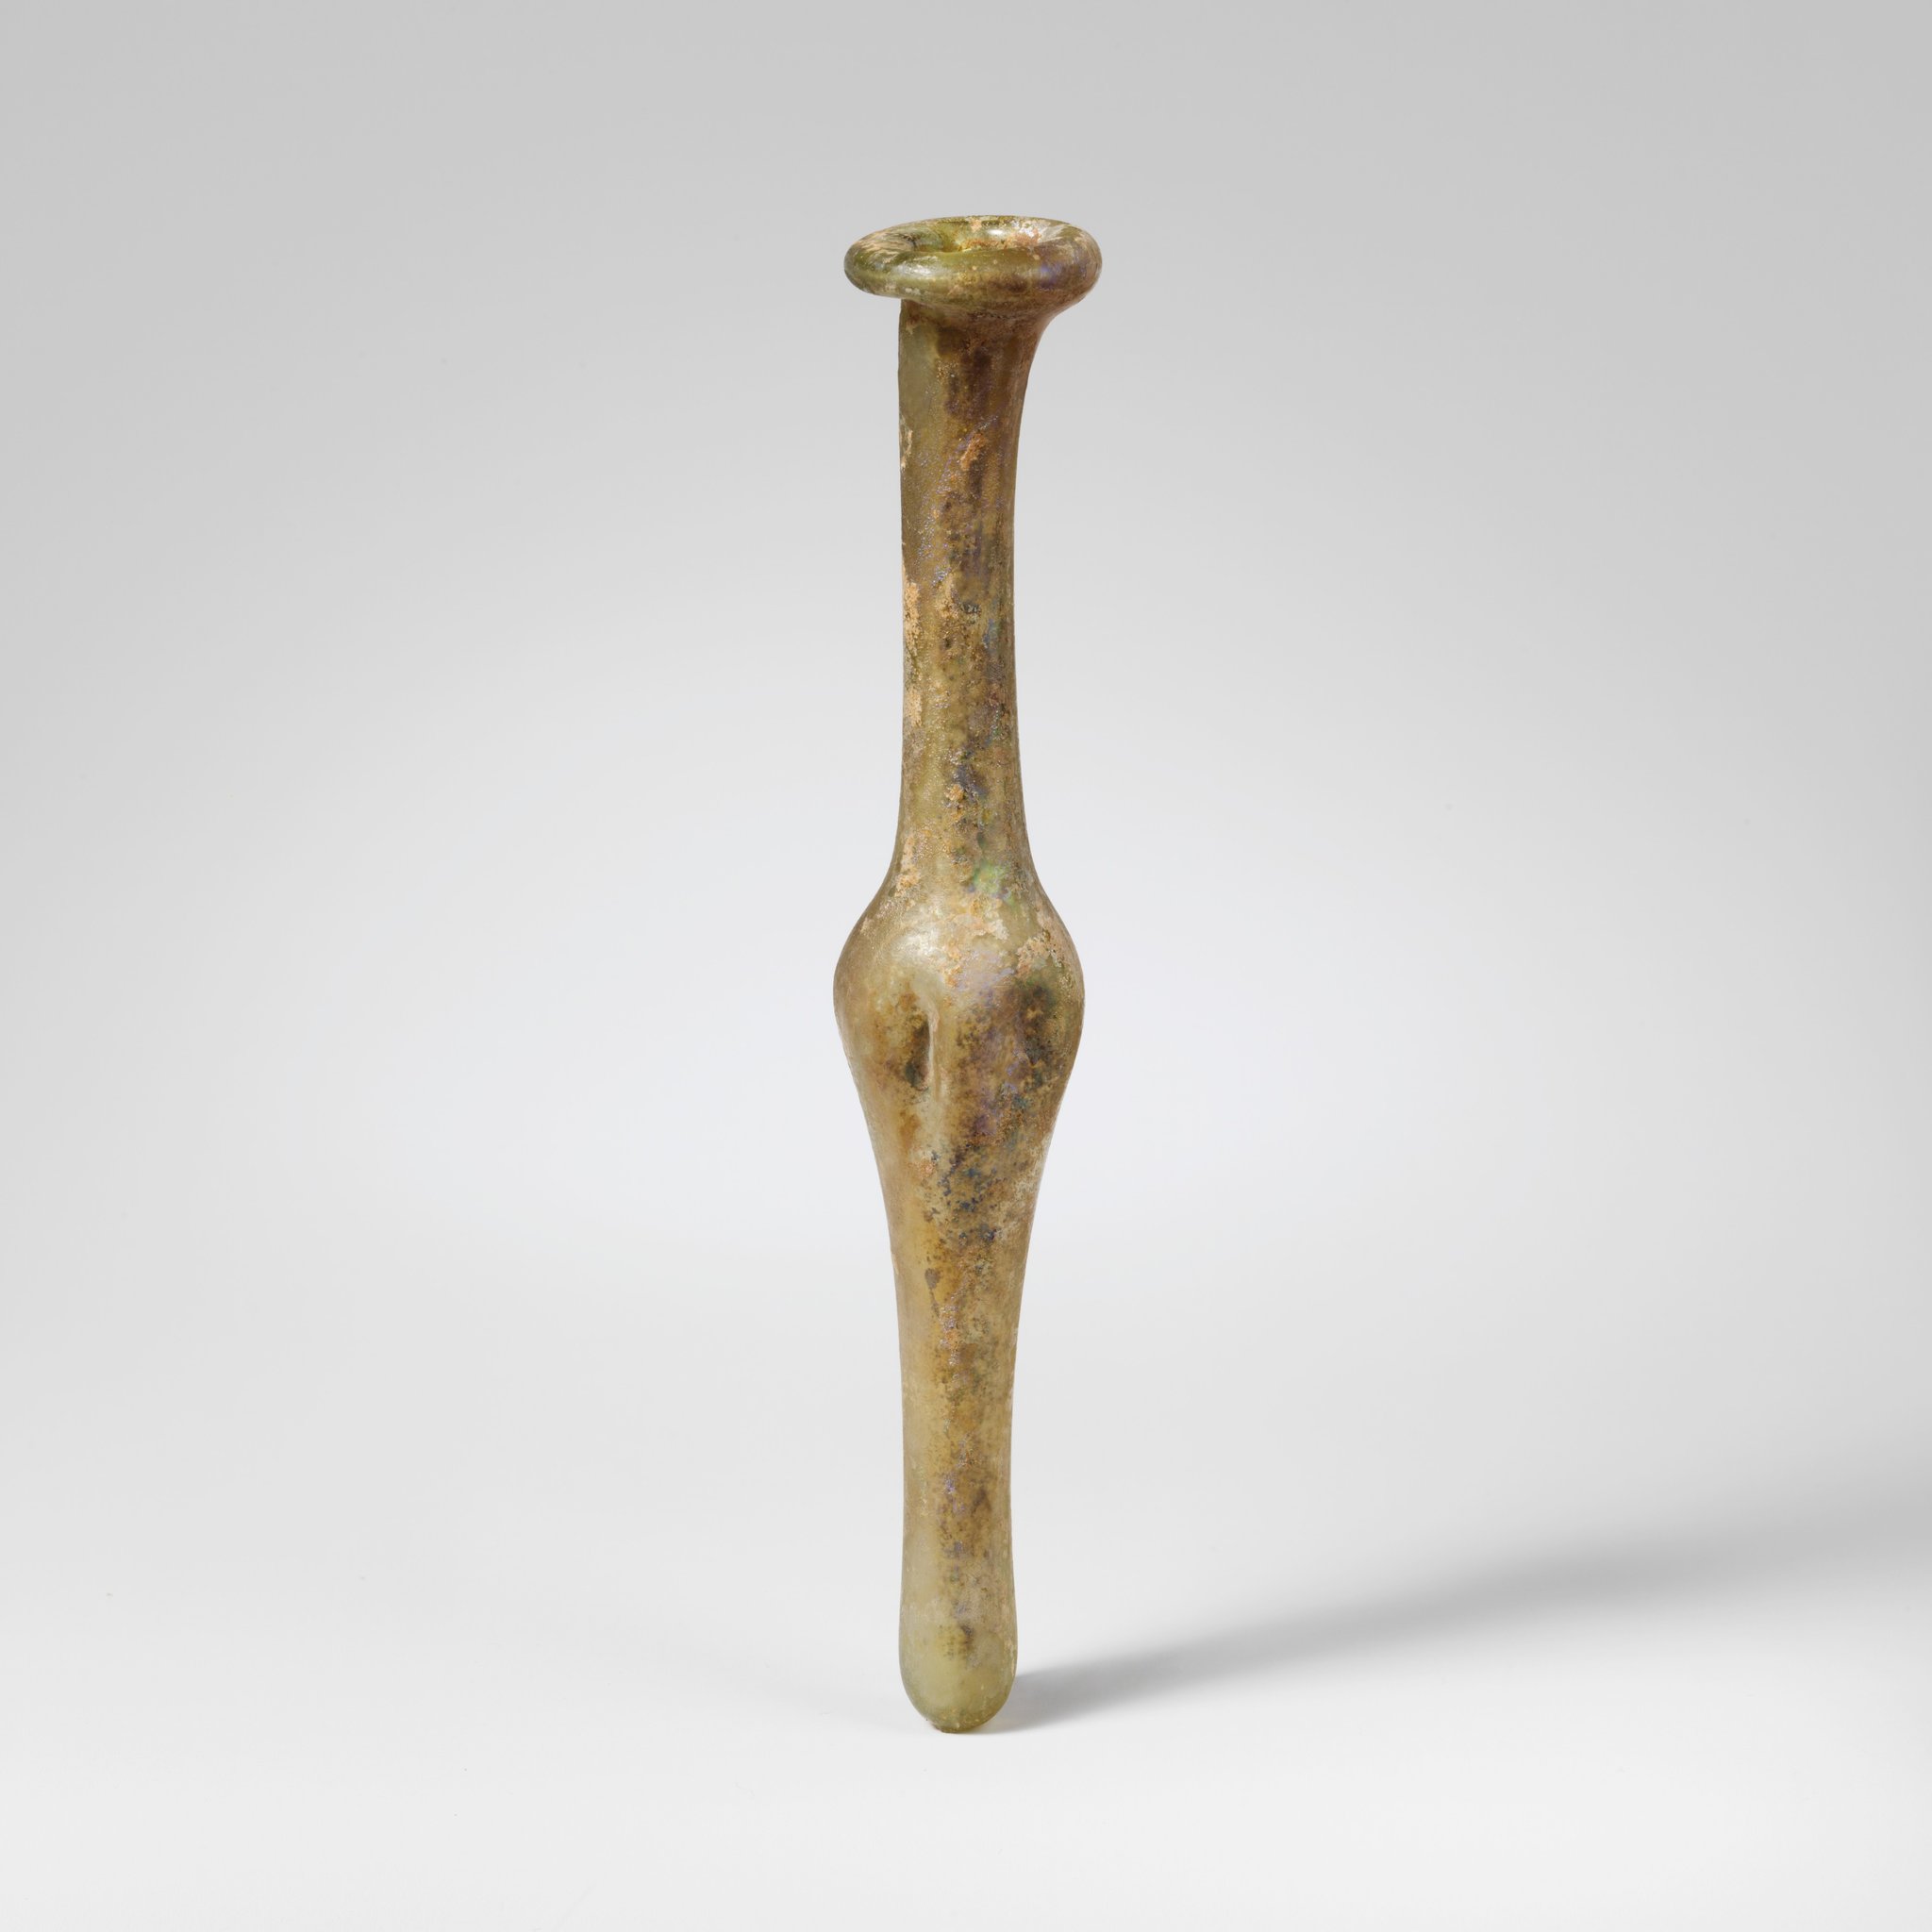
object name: bottle, fusiform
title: Glass fusiform bottle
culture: roman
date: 201-400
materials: glass